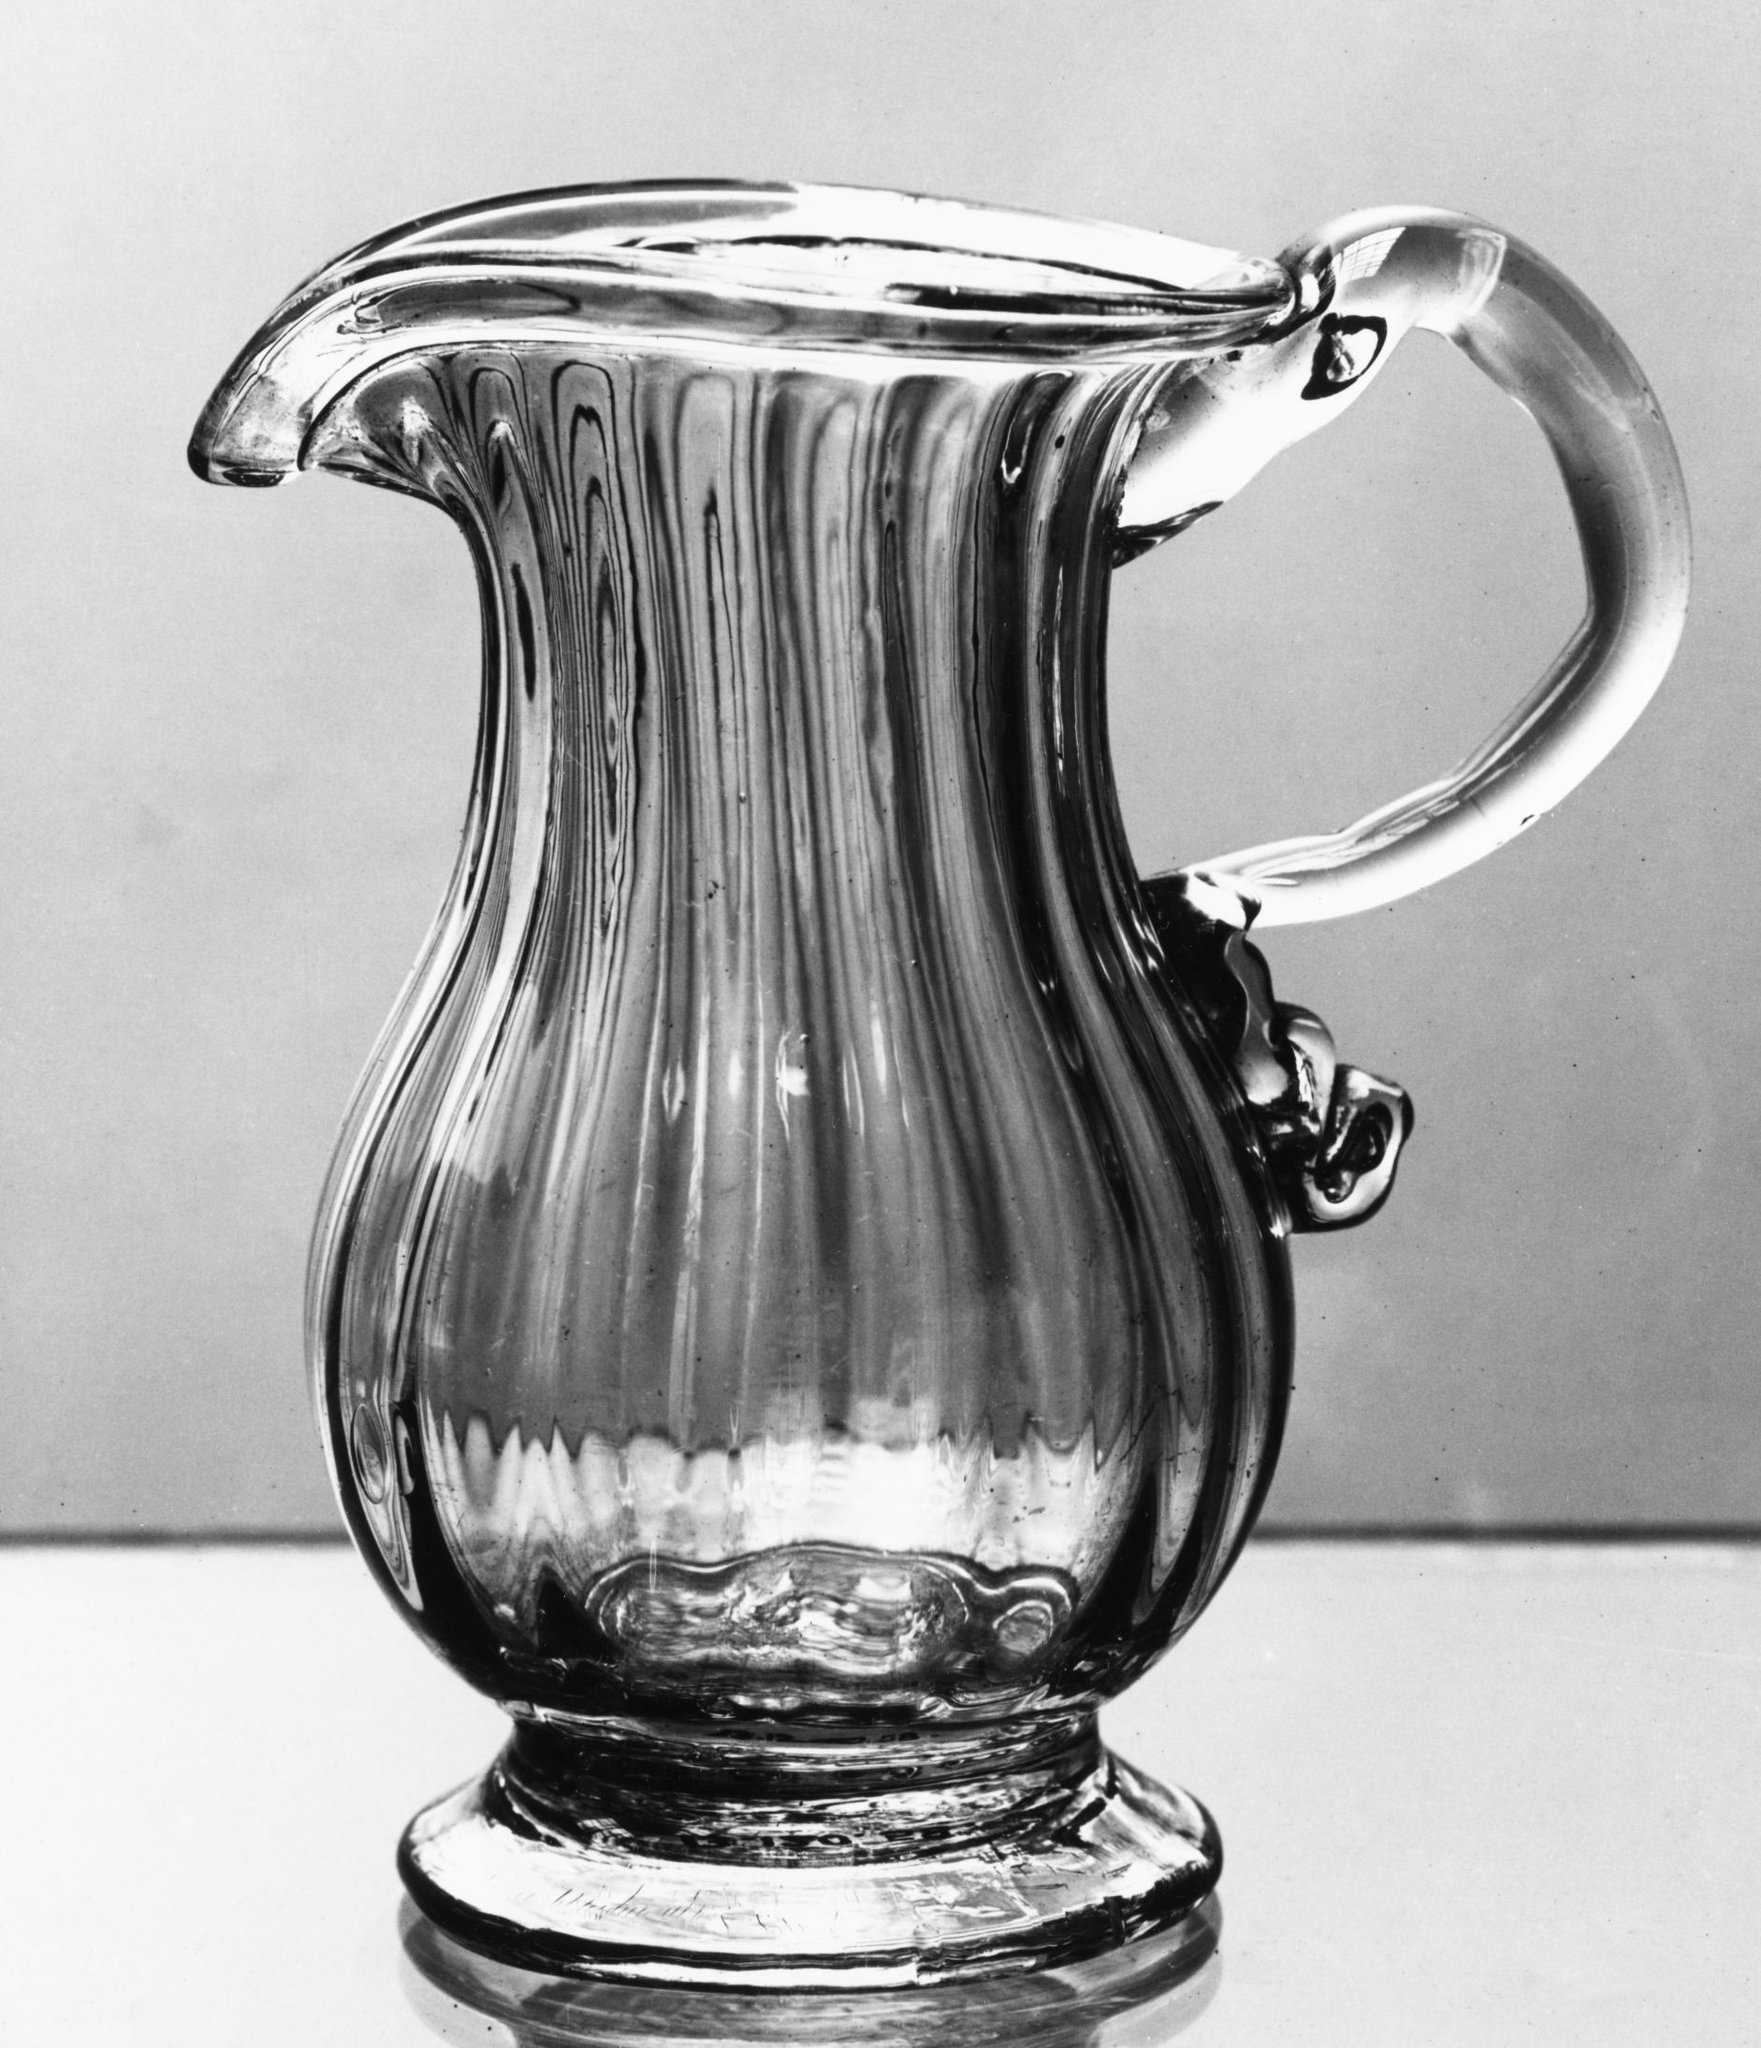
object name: cream jug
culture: british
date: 1780-1825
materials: glass, lead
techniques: glassblowing, molding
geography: england